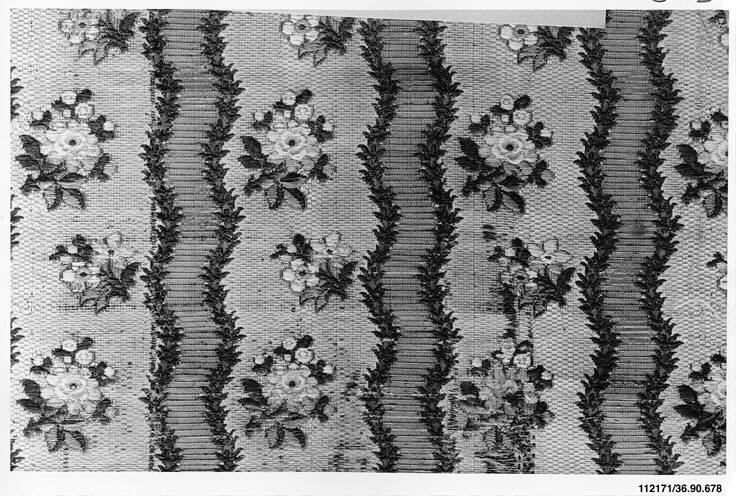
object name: piece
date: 1701-1800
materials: silk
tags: flowers,leaves